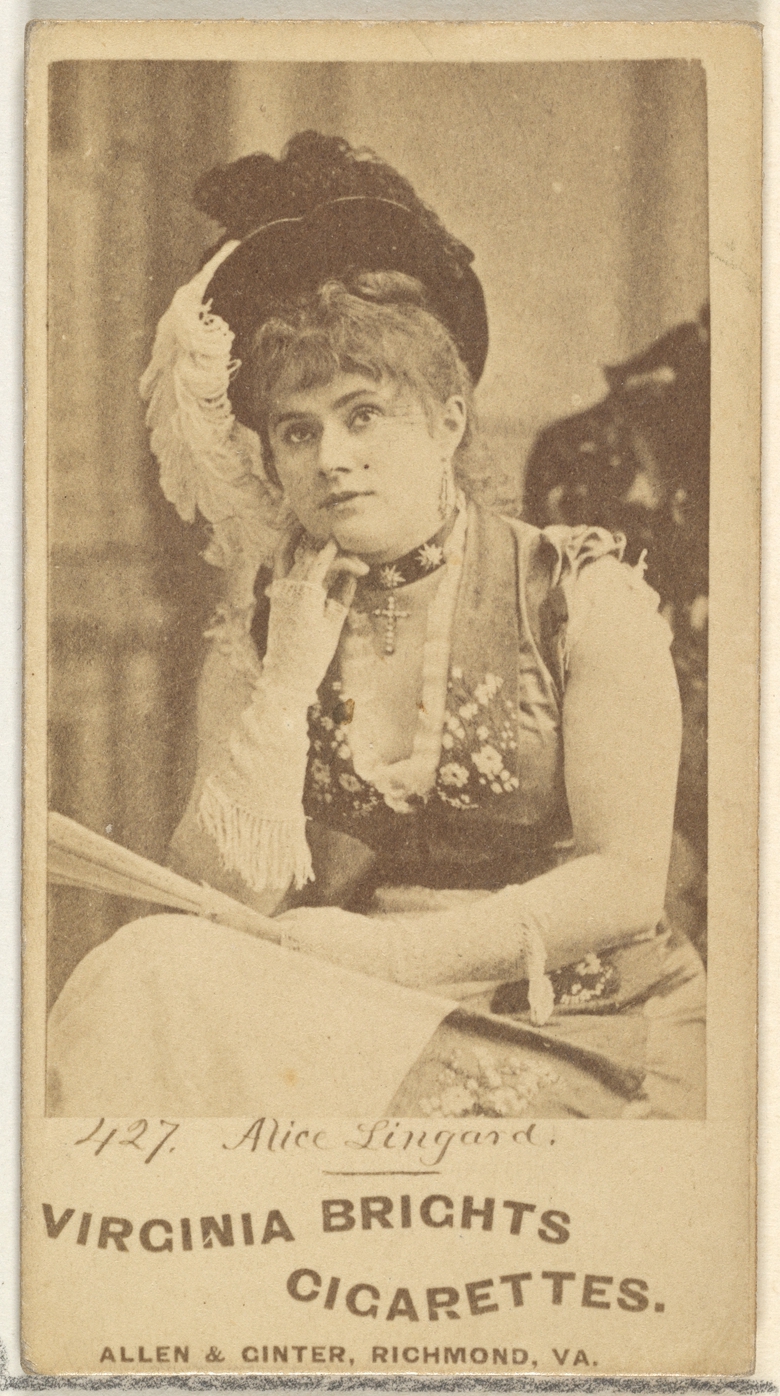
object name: photograph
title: Card 427, Alice Lingard, from the Actors and Actresses series (N45, Type 1) for Virginia Brights Cigarettes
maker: allen & ginter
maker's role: publisher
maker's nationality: american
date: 1888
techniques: albumen silver print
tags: portraits,women,actresses